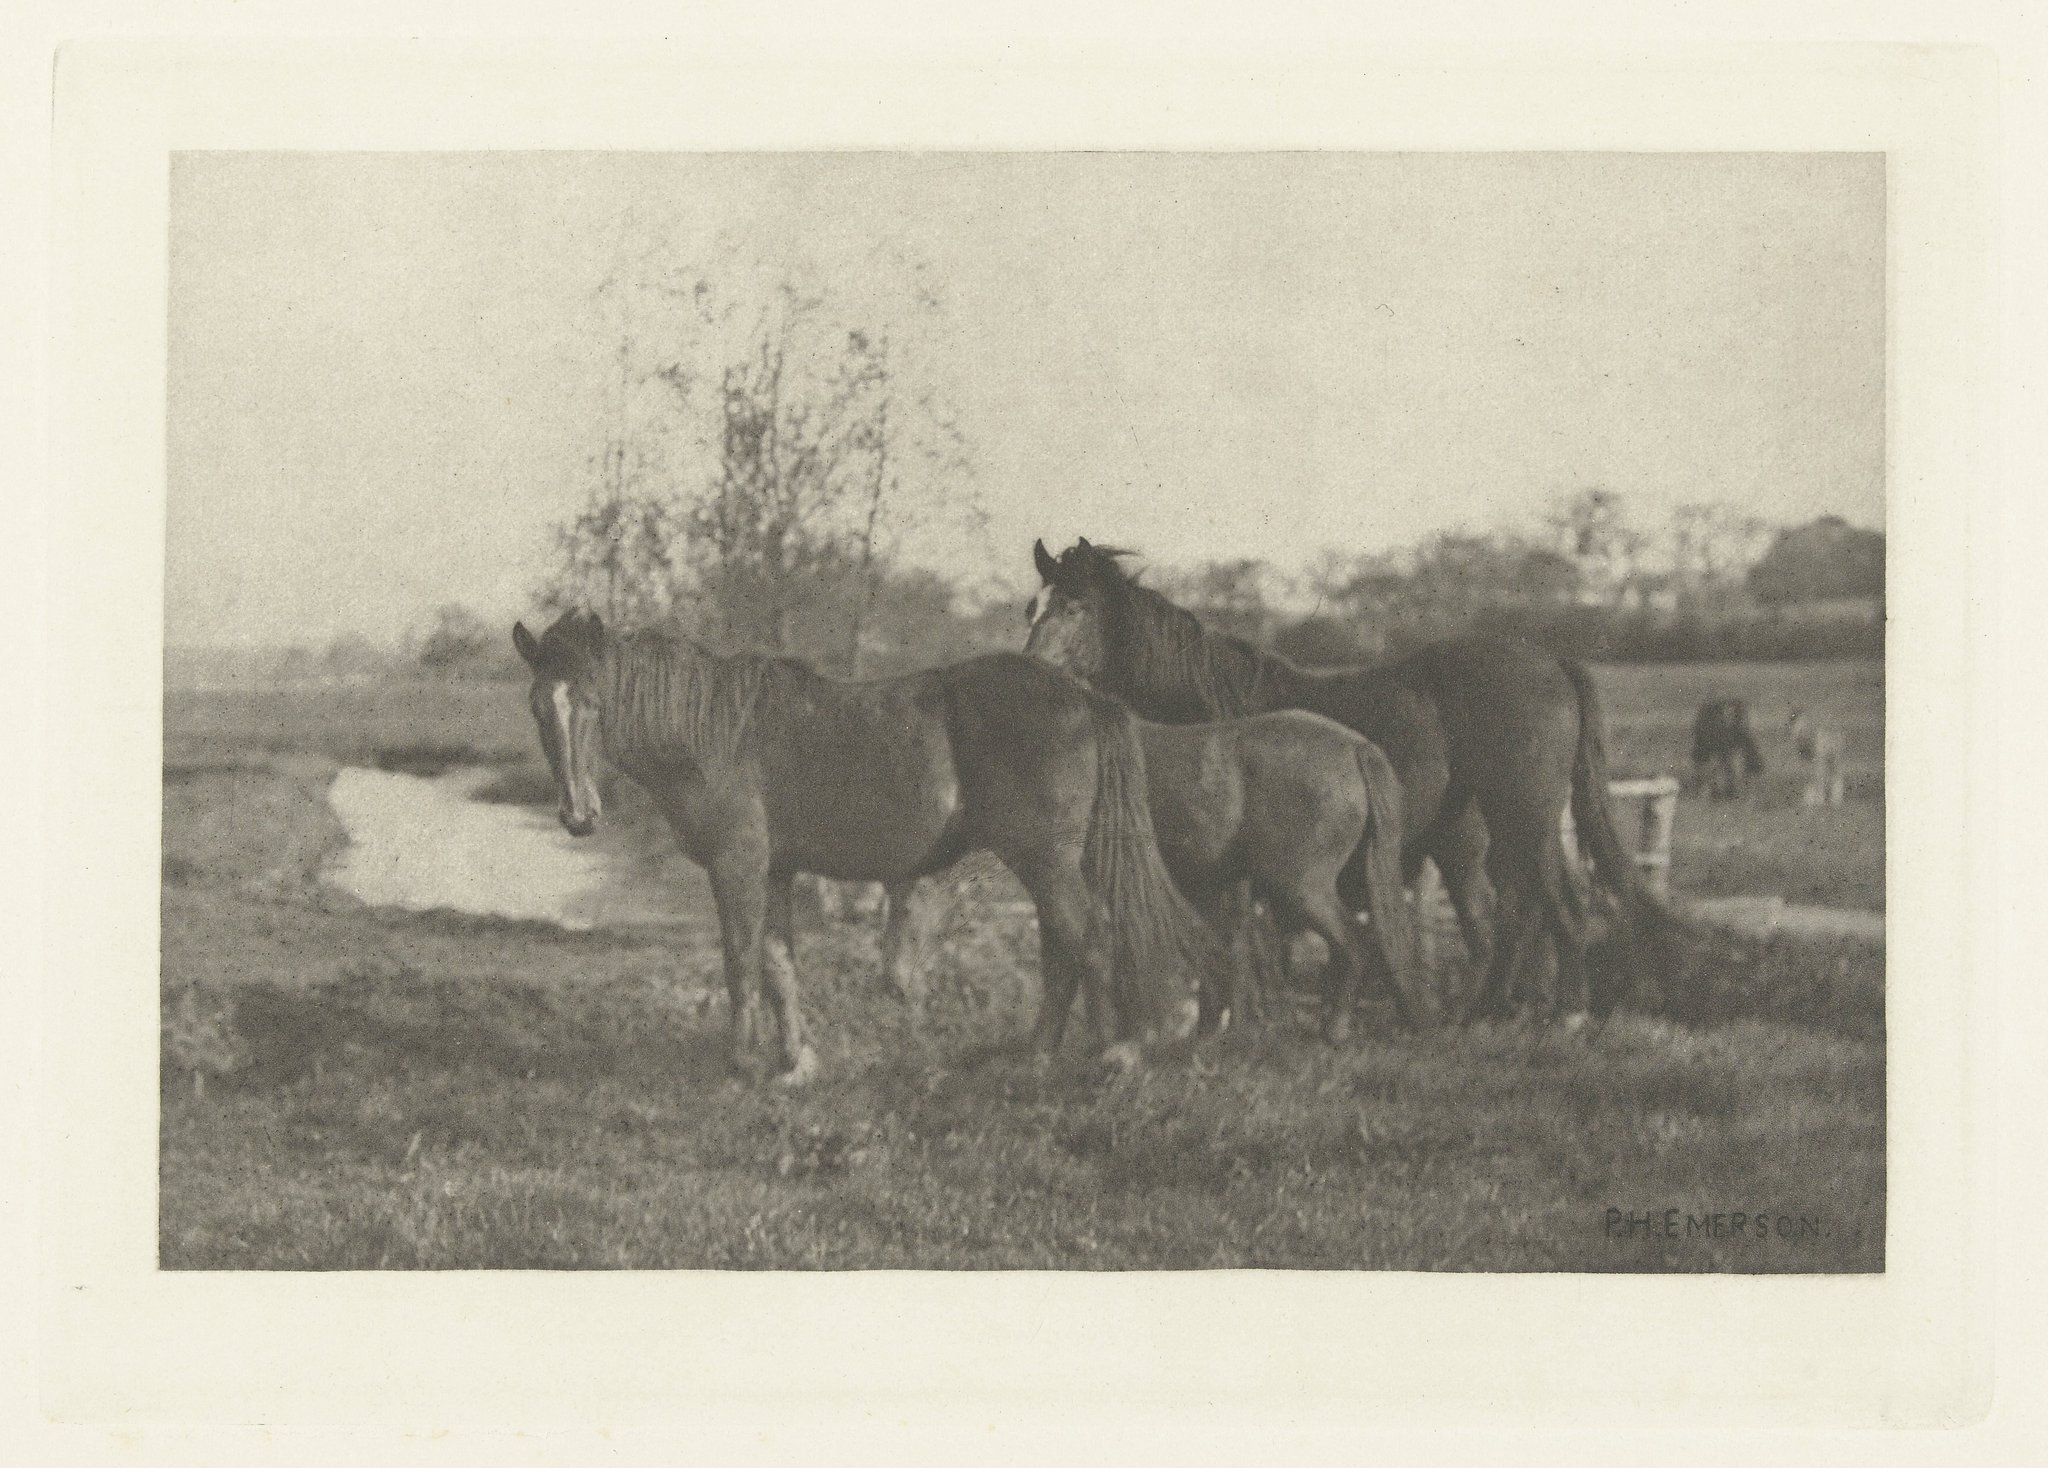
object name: photomechanical print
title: Colts on a Norfolk Marsh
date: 1883-1888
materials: paper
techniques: photoaquatint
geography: great britain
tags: horse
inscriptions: inscription: ‘Plate V.’